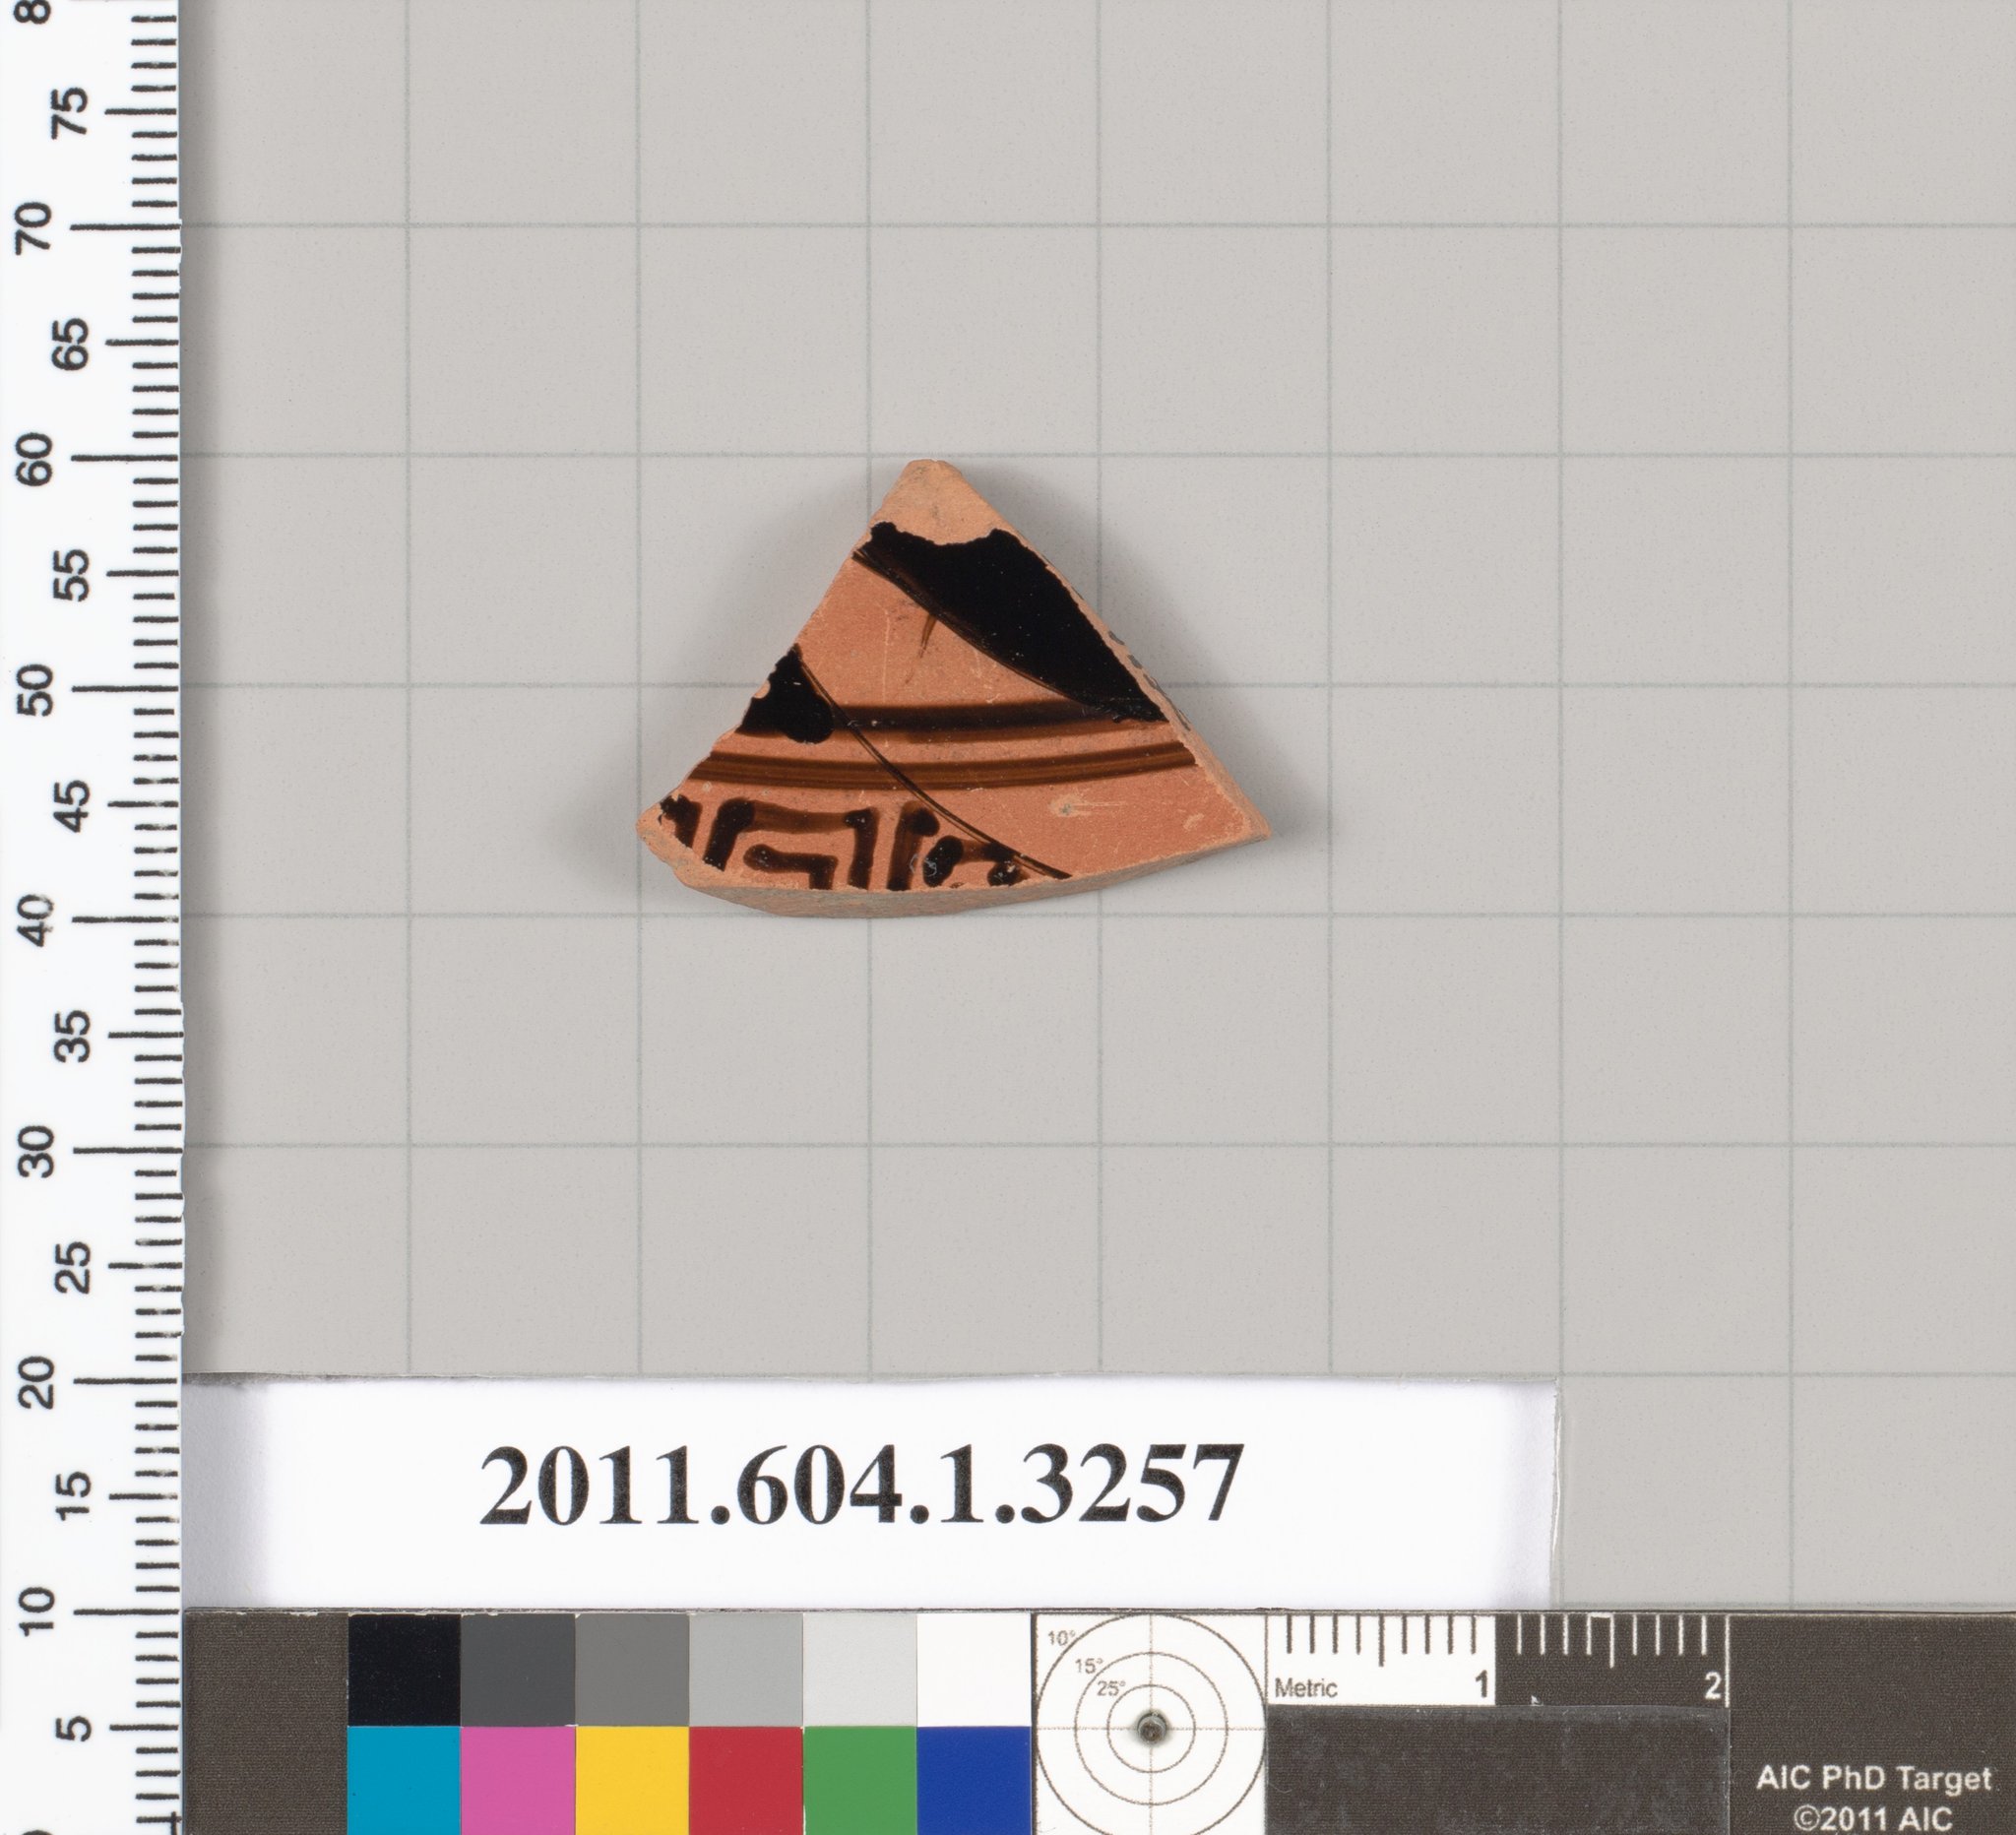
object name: kylix fragment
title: Terracotta fragment of a kylix (drinking cup)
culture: greek, attic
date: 500-476 BCE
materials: terracotta